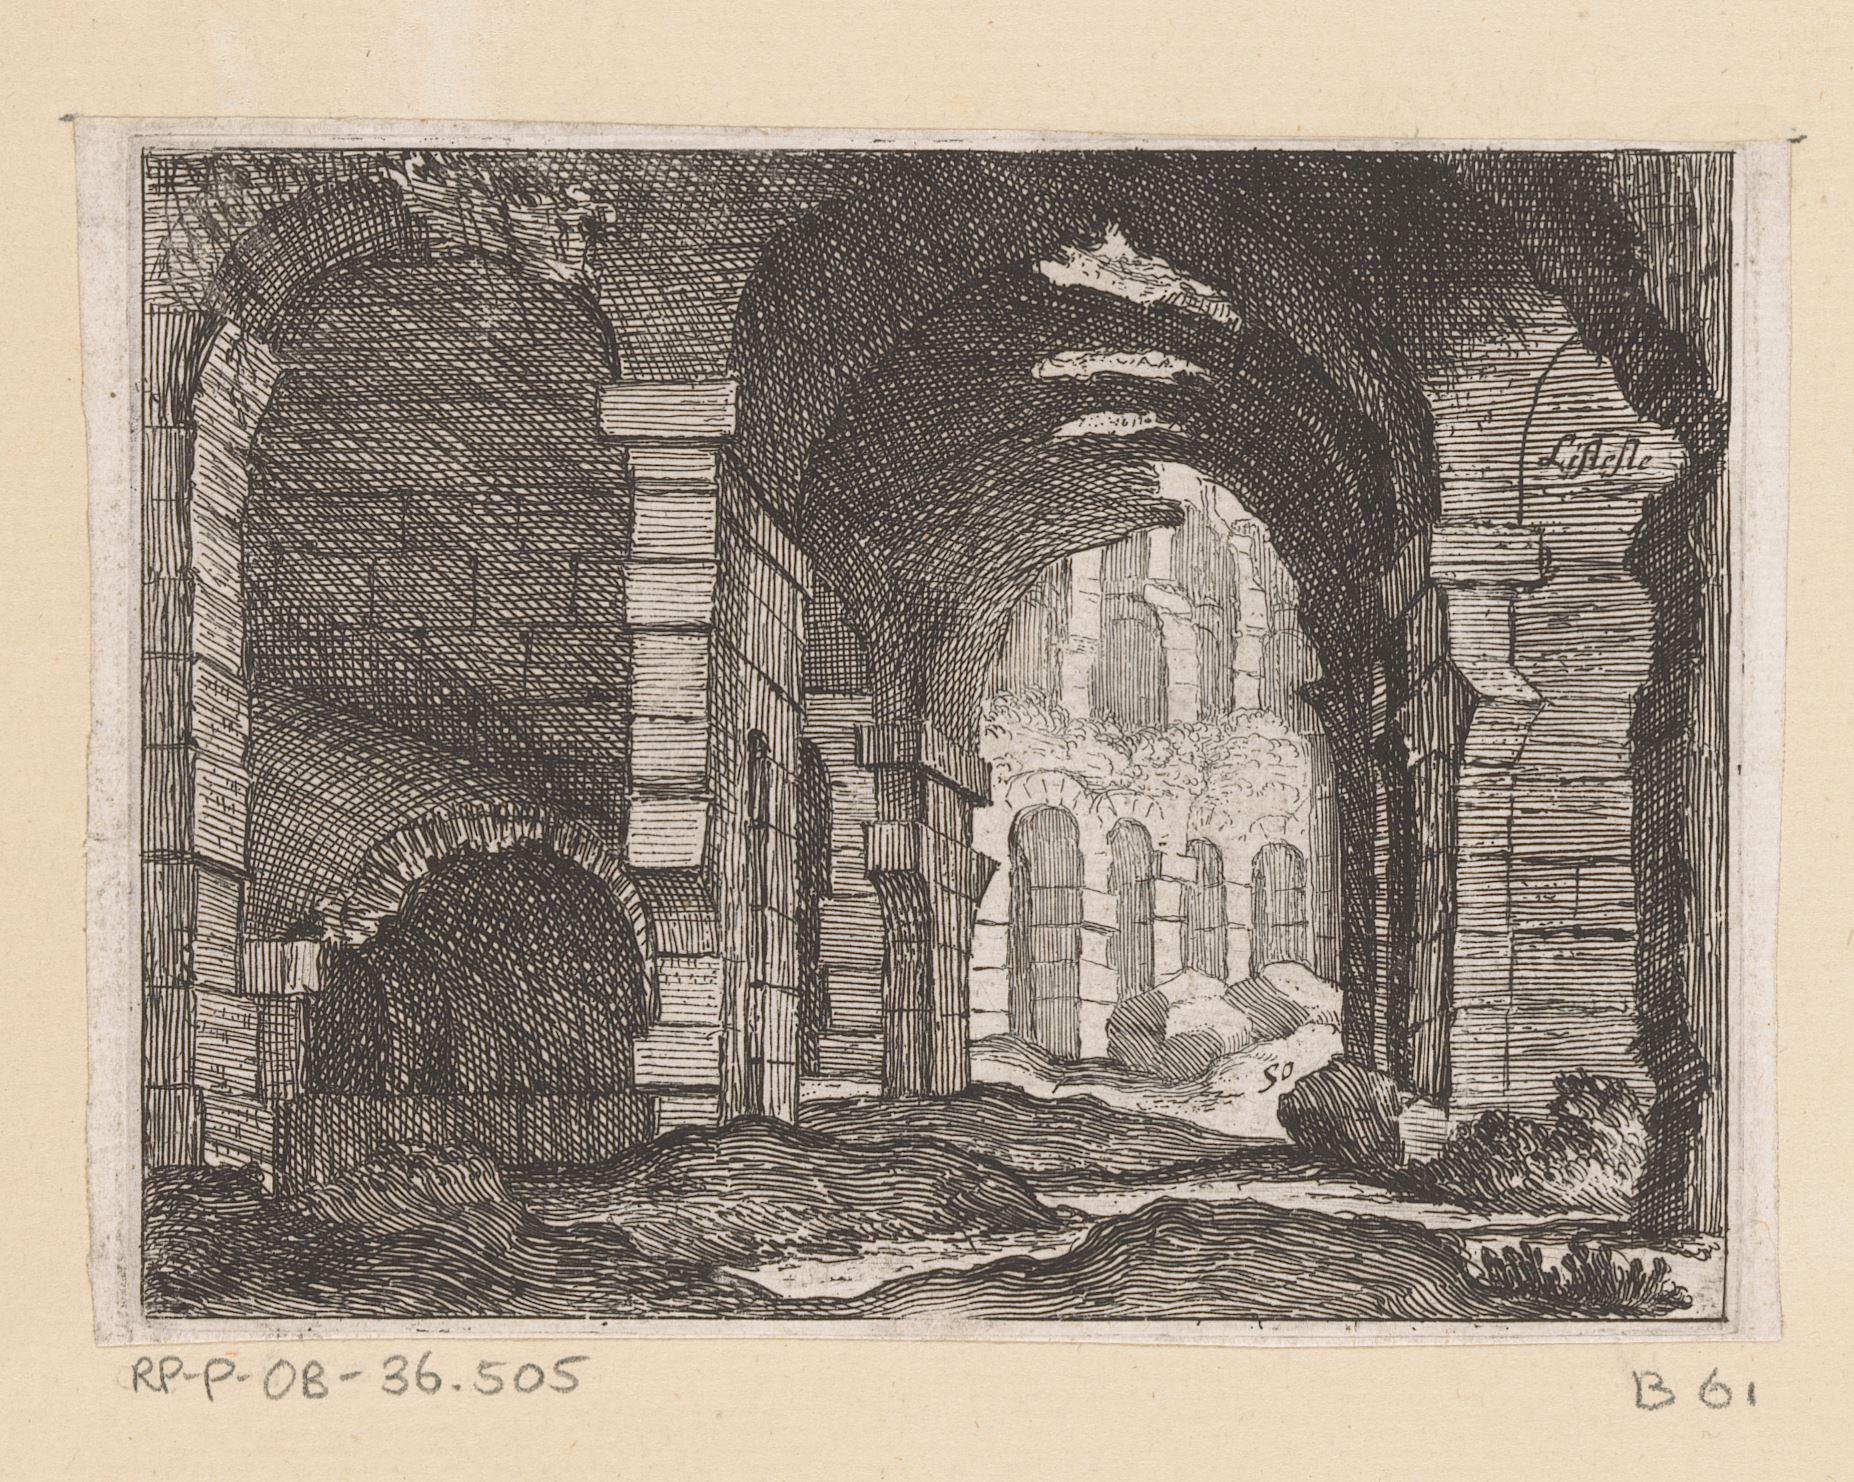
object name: print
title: Gezichten op Rome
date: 1629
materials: paper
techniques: etching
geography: tuscany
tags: landscape with ruins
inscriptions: collector's mark: Lugt 2228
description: Deze prent maakt deel uit van een reeks van 52 prenten.